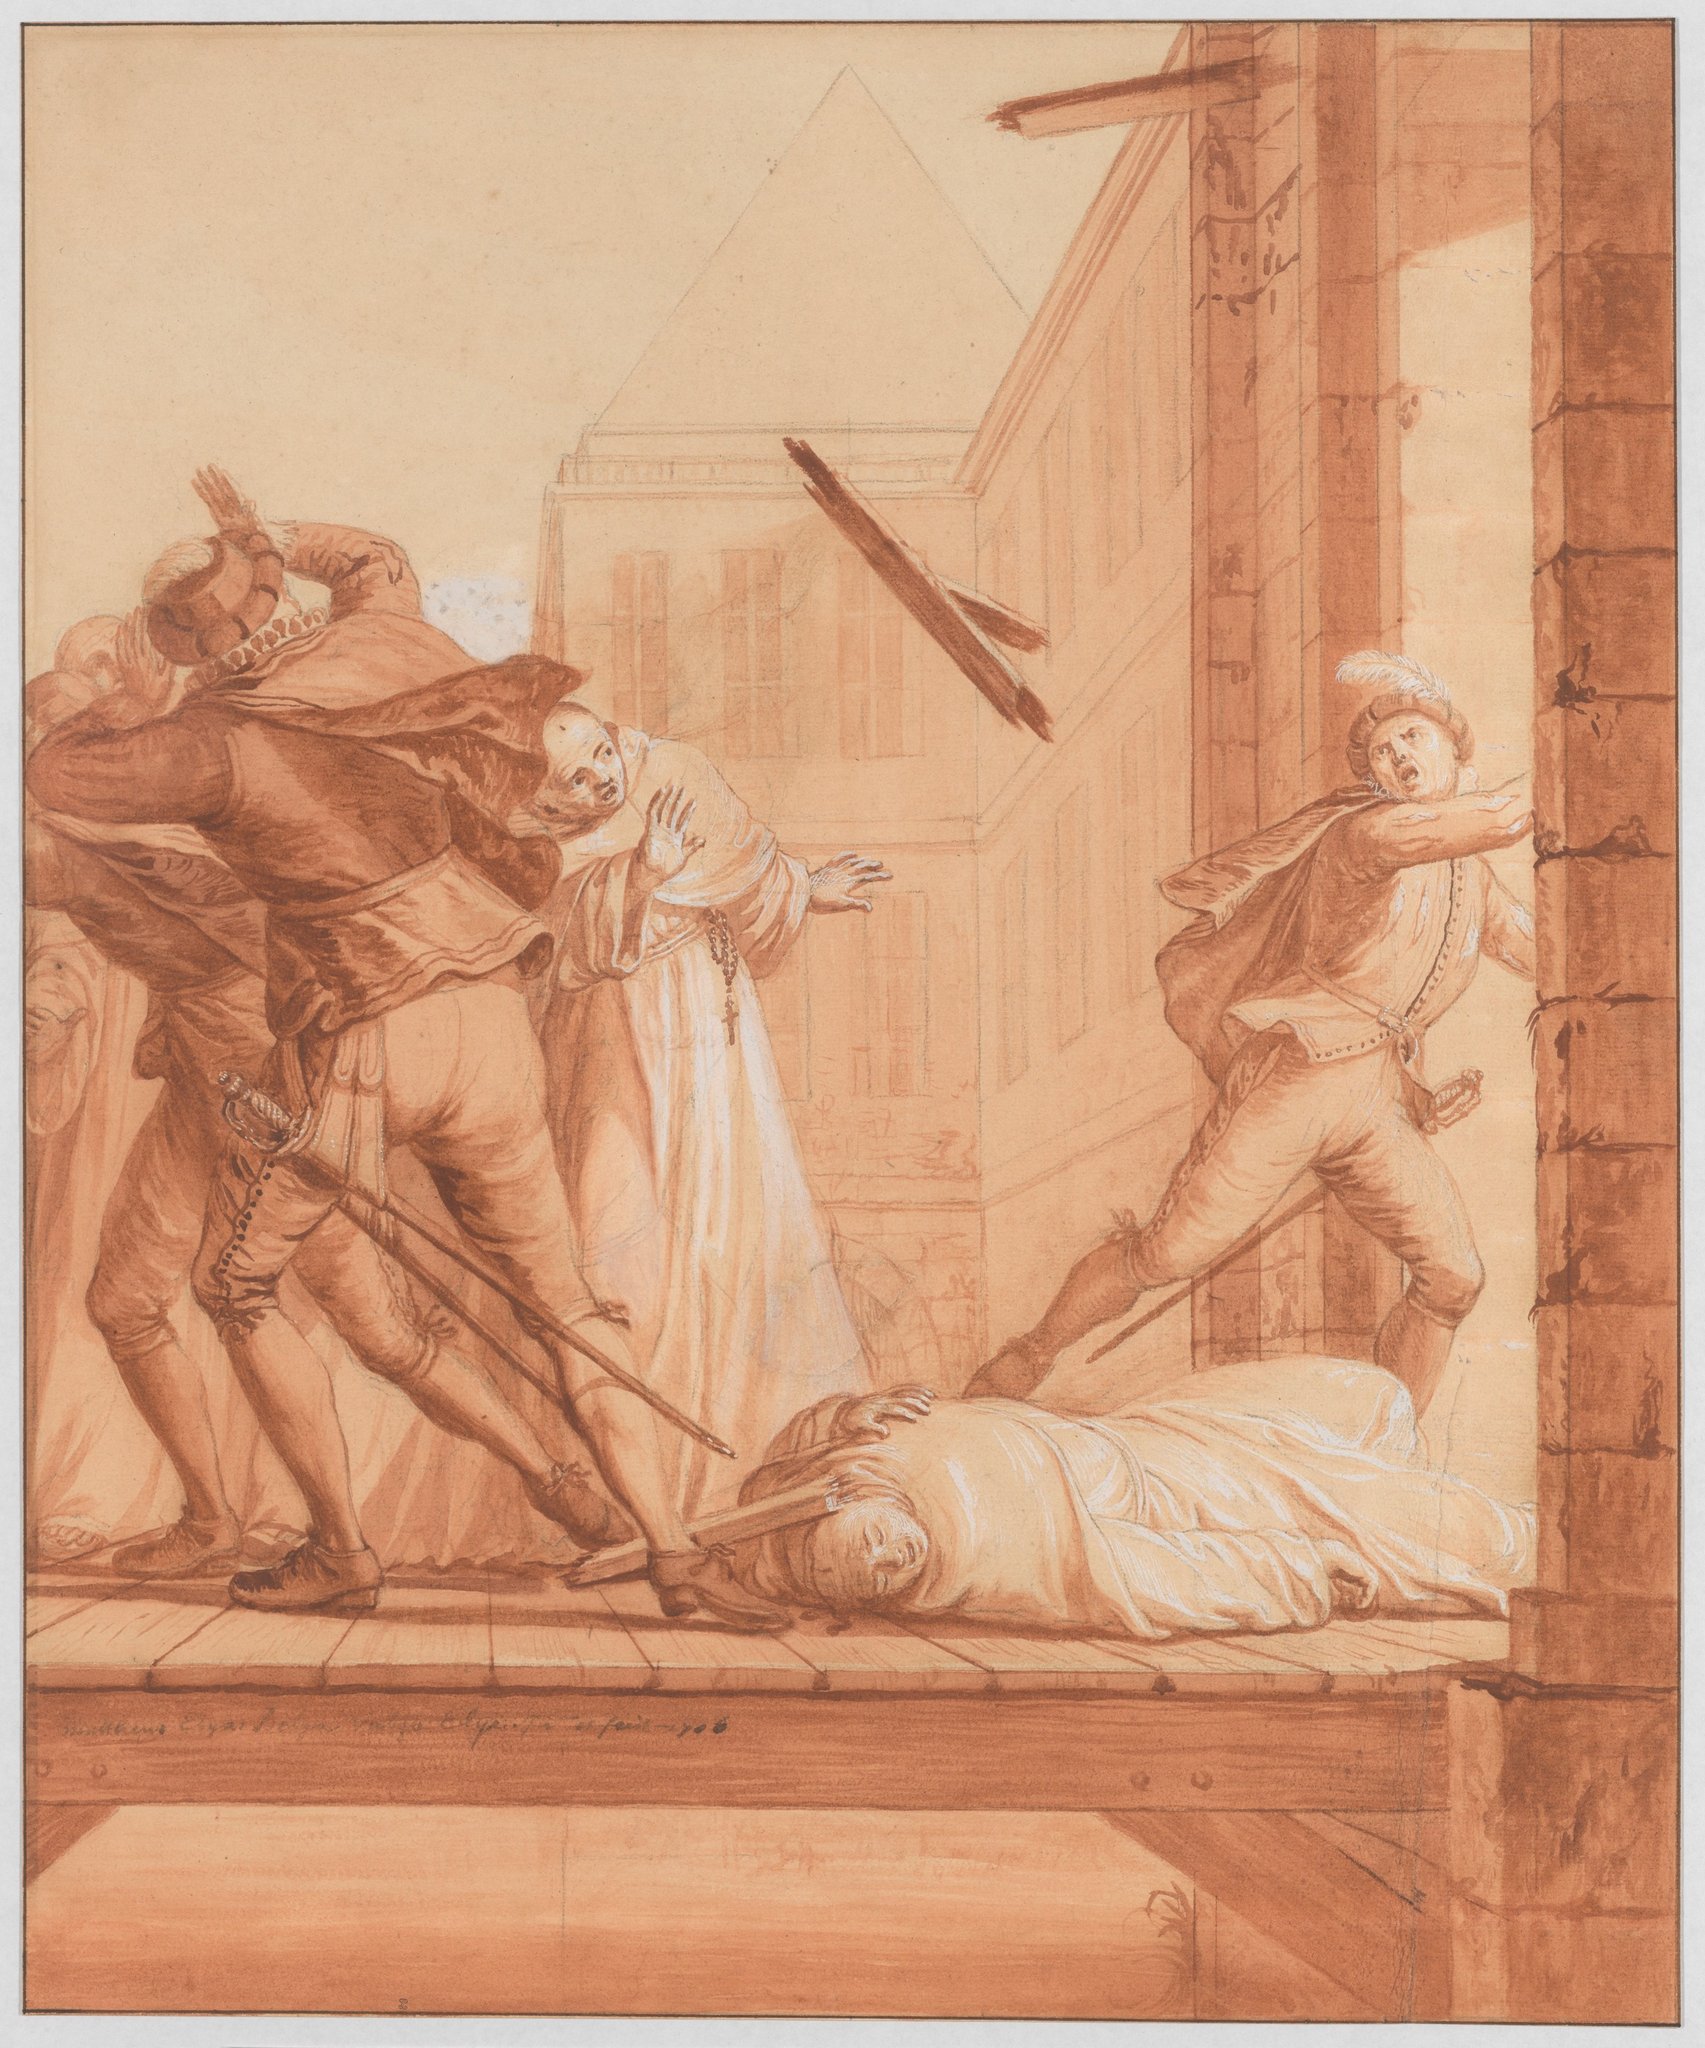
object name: drawing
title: Scene 28: The Blessed Abbot having retired to the Château de Montaigu, soldiers of the league arrive to capture him as he leaves. A piece of wood falls from on high and scatters the soldiers and wounds the Holy Abbot, whom they leave for dead; he is miraculously cured and escapes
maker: matthieu elias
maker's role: artist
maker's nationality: french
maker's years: 1658-1741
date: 1706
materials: chalk, graphite, ink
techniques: brush, heightening, pen, wash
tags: anger,men,monks